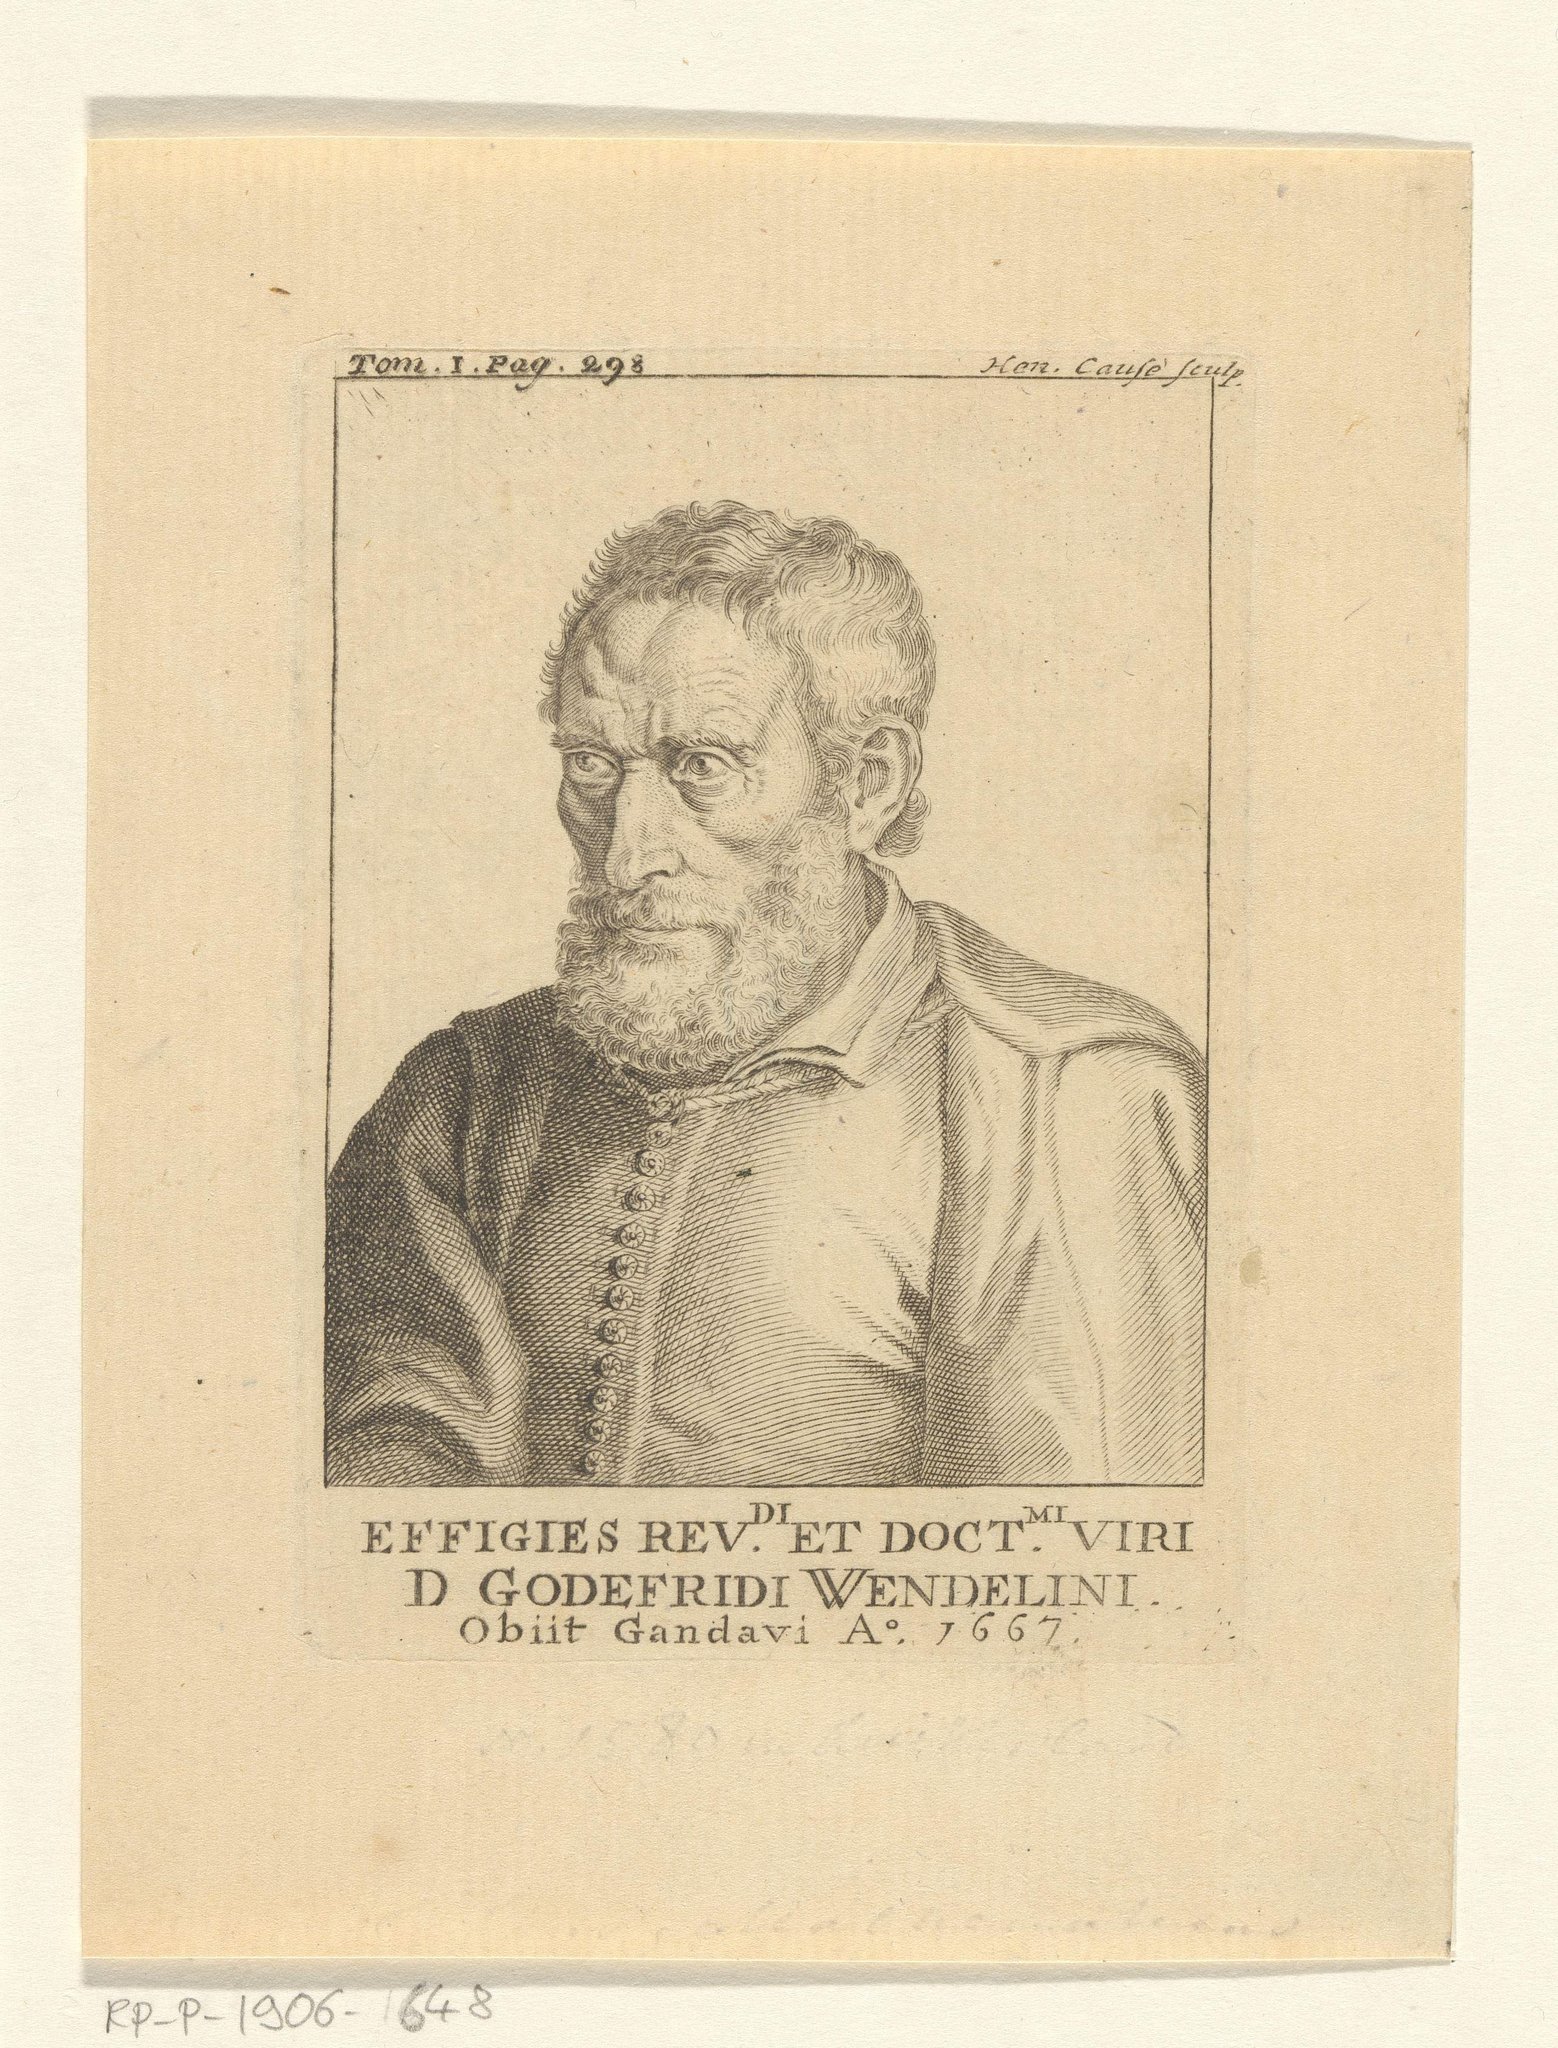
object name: book illustration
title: Portret van de sterrenkundige Godefridus Wendelinus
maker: hendrik causé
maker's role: print maker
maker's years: 1648-1699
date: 1667-1699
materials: paper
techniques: engraving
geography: southern netherlands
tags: sterrenkundige, godefridus wendelinus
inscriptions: collector's mark: Lugt 2228